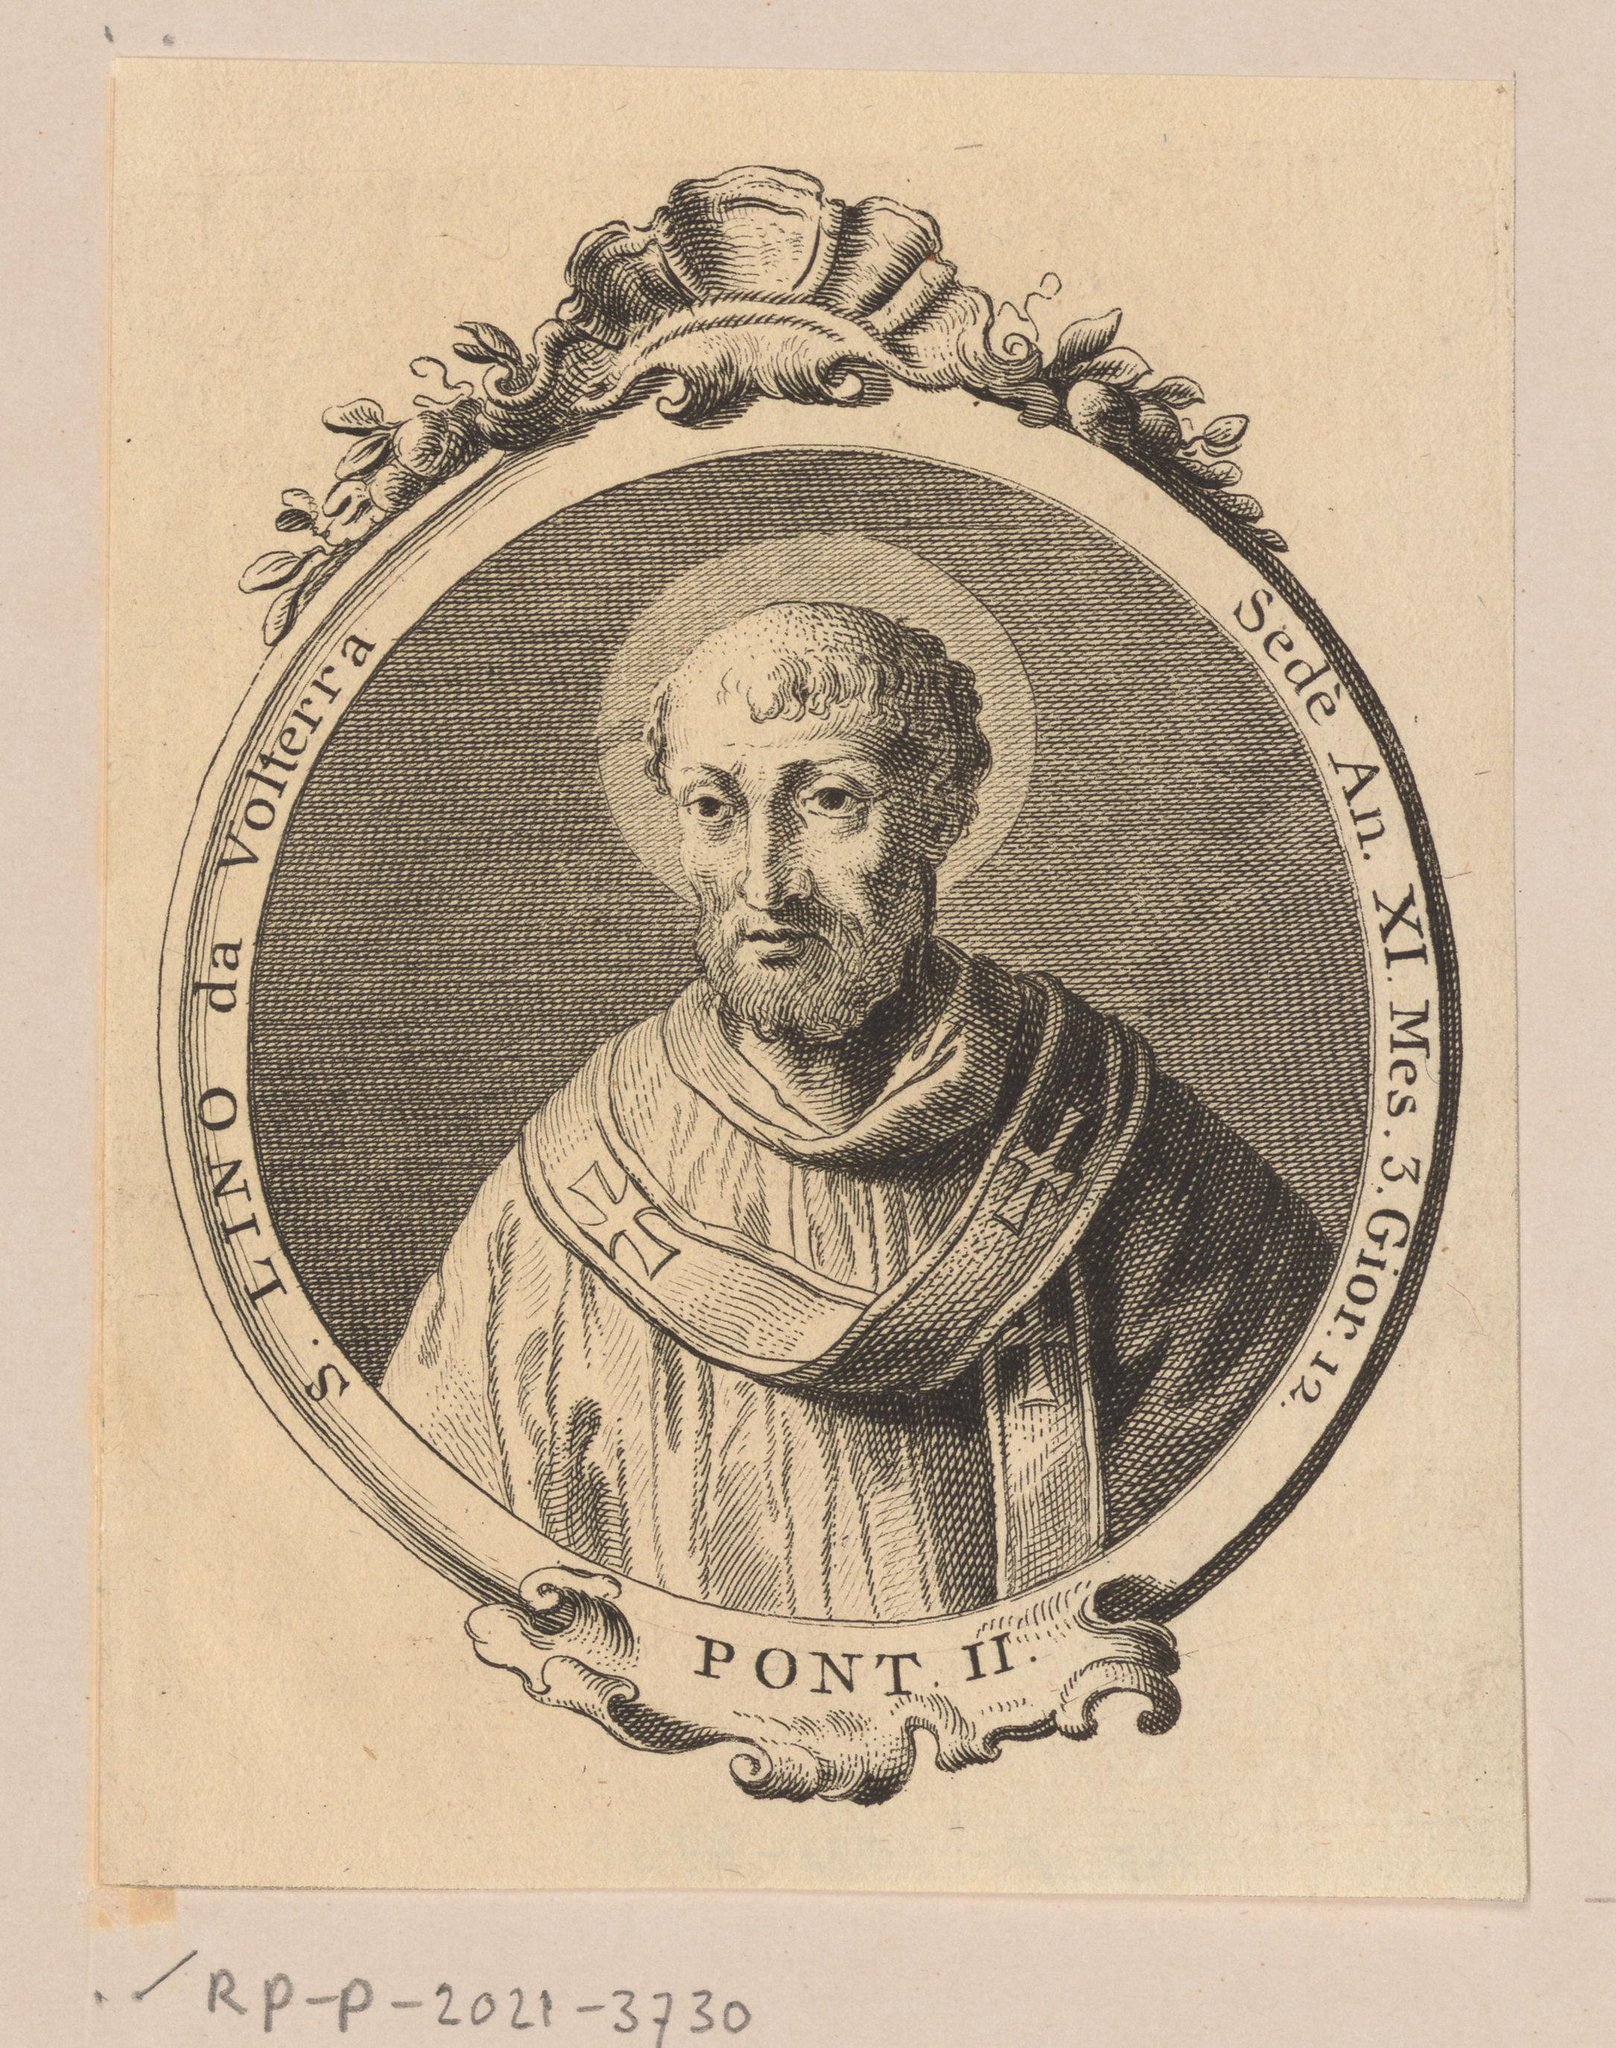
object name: book illustration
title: Portret van paus Linus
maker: Anonymous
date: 1775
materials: paper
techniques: etching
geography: italy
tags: rome, nimbus, halo ~ radiance emanating from persons or things, rocaille ornament, historical persons, pope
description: Prent waarschijnlijk uit: Effigies Romanorum pontificum a S. Petro ad Pium VI (...). 2 dln. Venetië en Bassano del Grappa: Giuseppe Remondini, 1775. Prent met tekst in boekdruk op verso eerder gebruikt in: Platina (Bartholomaeus Sacchi). Storia delle vite dei pontefici da Platina e d'altri autori (...). 5 dln. Venetië: Domenico Ferrarin, 1760, dl. 1.